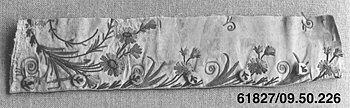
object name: fragment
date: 1701-1800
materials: silk, thread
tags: flowers,leaves